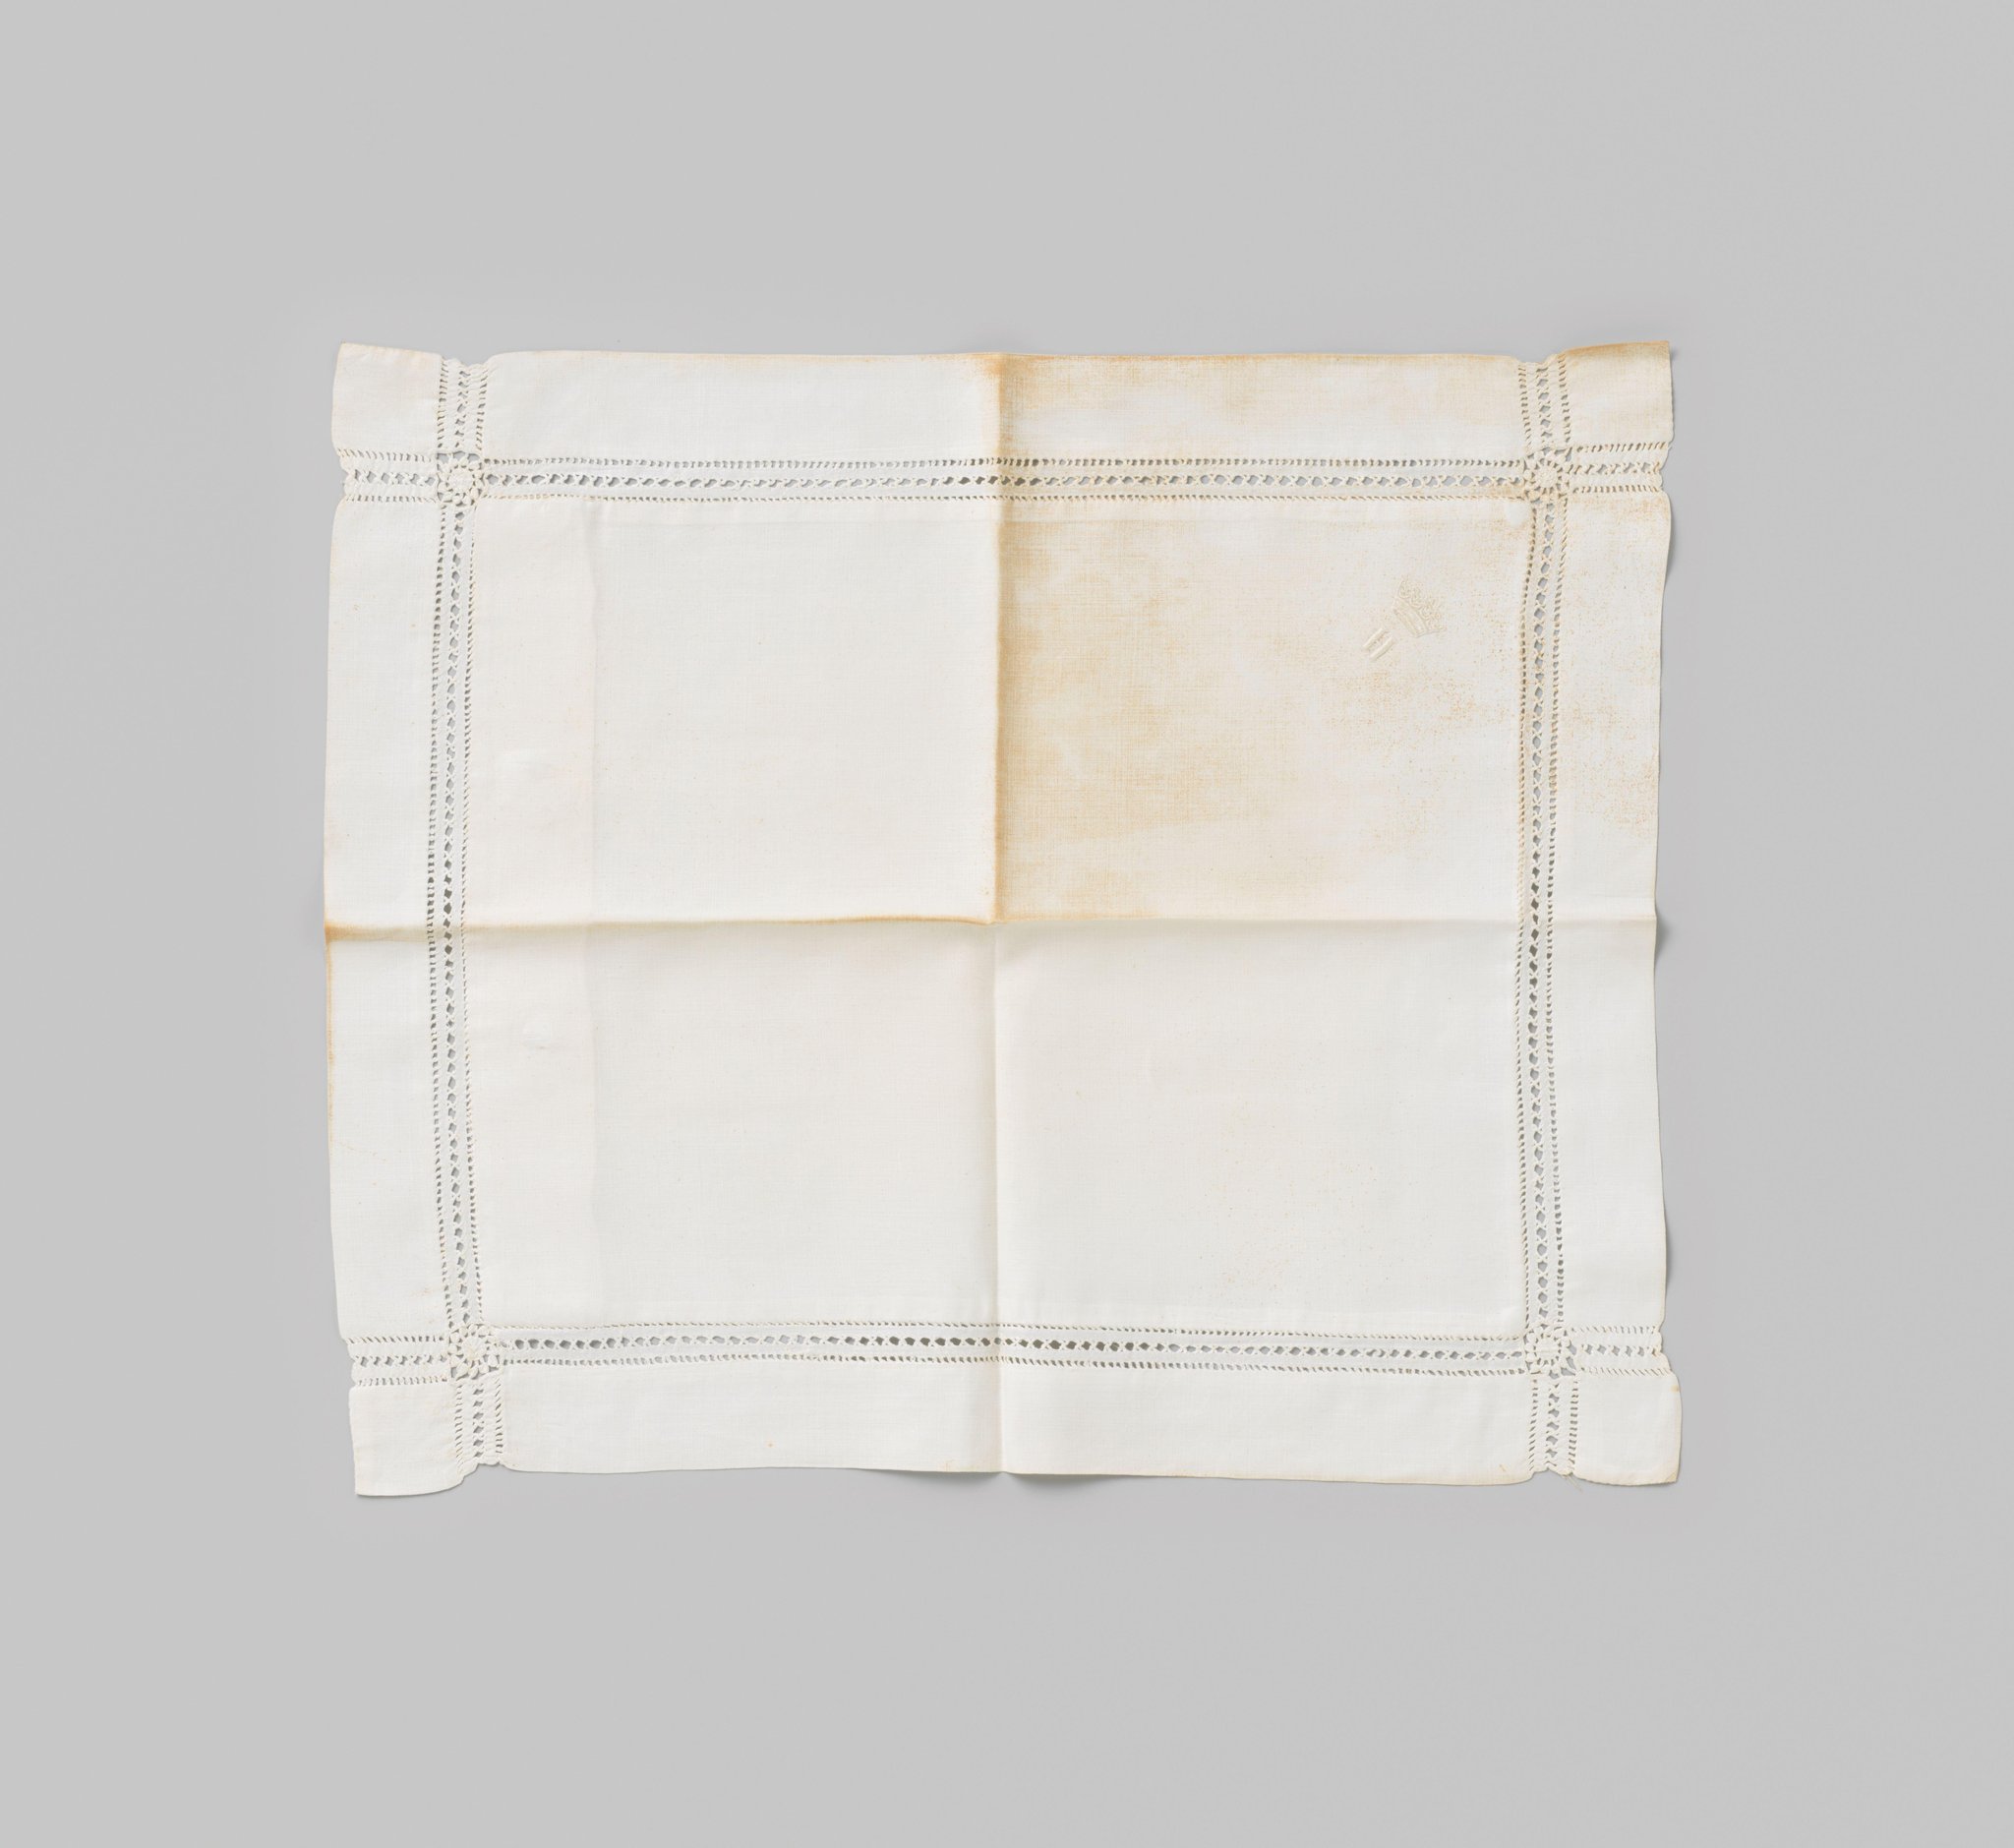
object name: sloop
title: Lendesloop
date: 1880-1920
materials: linen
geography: northern netherlands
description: Wit linnen lendesloopje met opengewerkte randen, merk kroon H WH 2oonl.